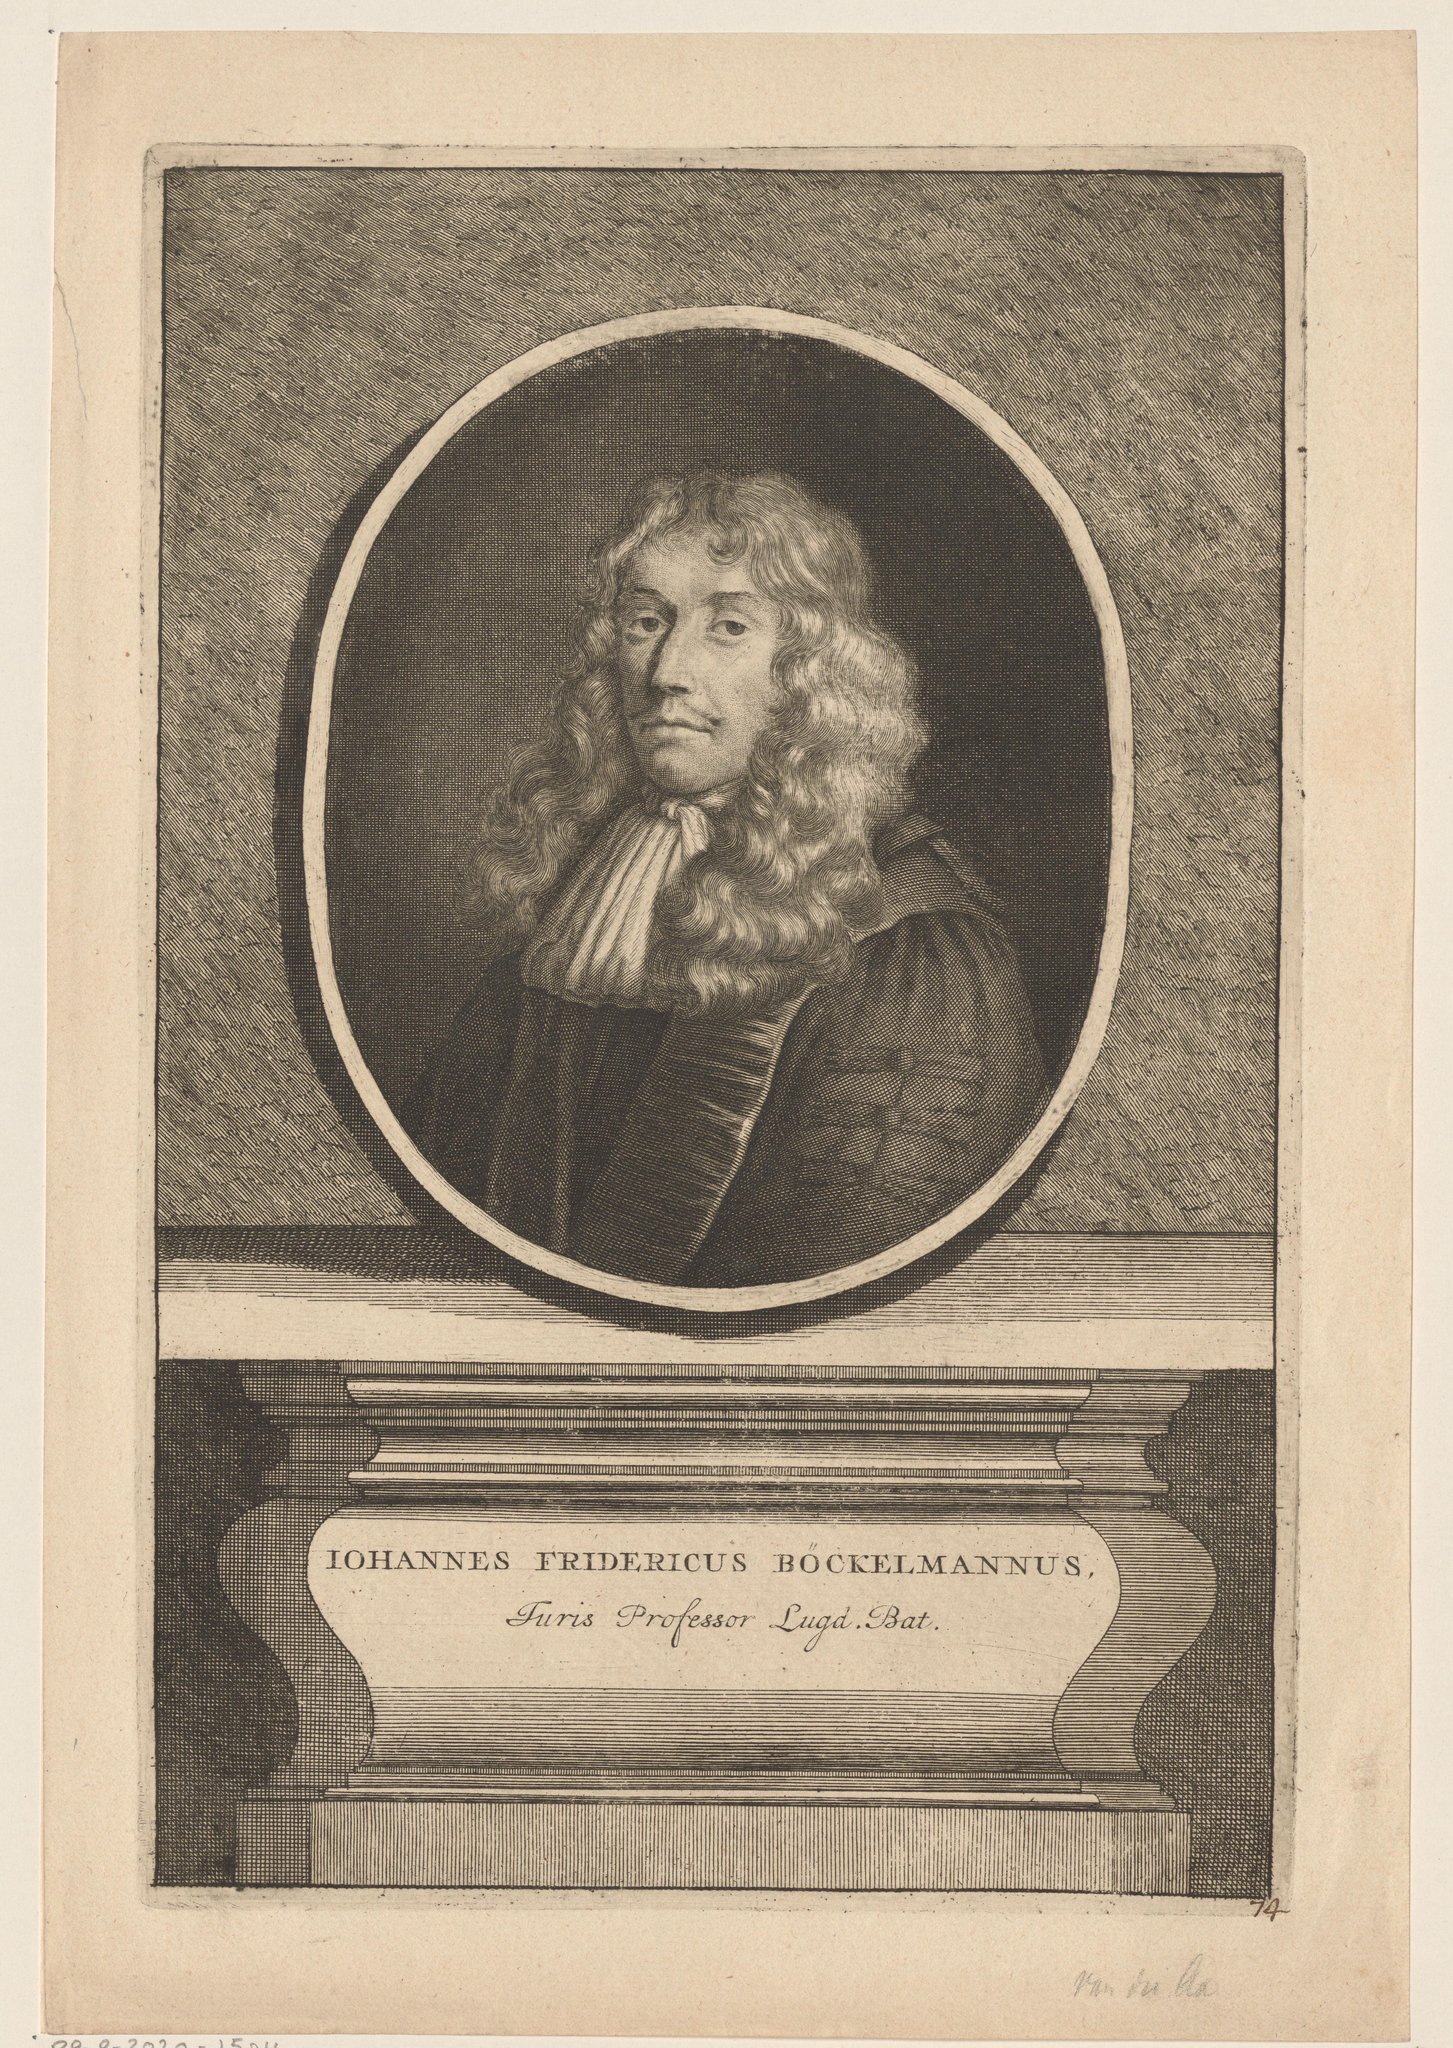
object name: print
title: Beroemde mannen aan de universiteit van Leiden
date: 1716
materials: paper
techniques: engraving, etching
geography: leiden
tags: historical persons, professor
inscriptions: inscription: ‘74’